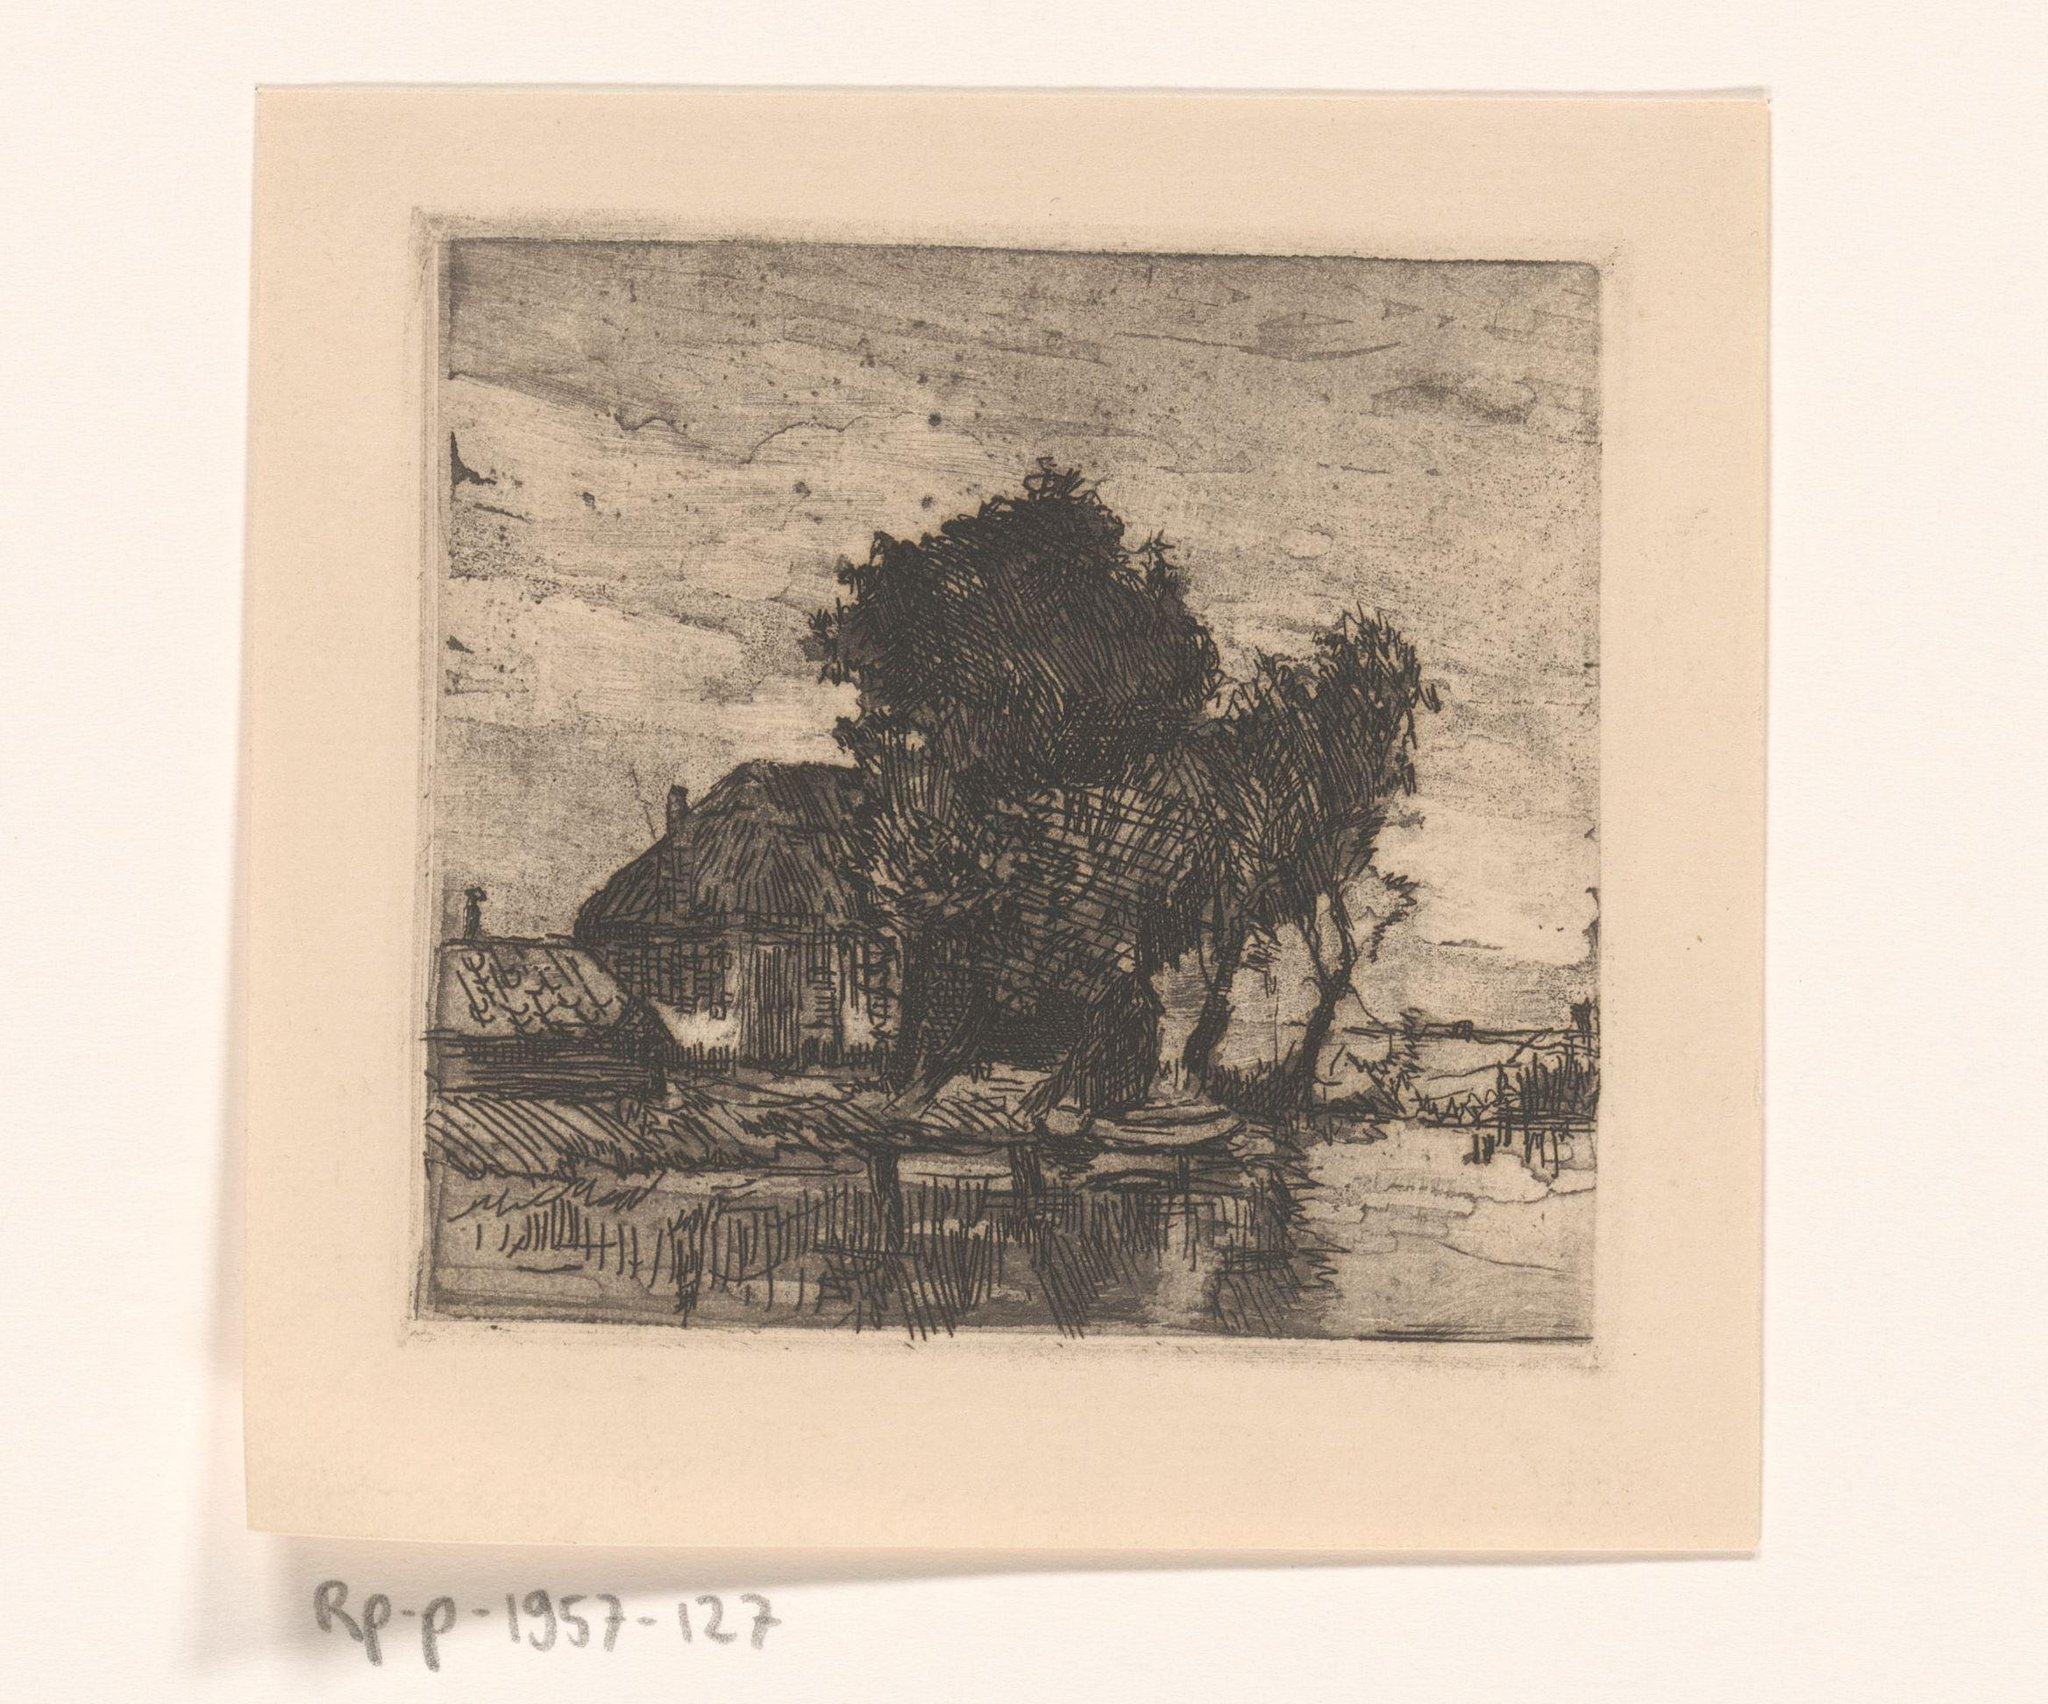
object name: print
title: Boerderij aan een plas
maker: chris van der windt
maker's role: print maker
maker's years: 1877-1952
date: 1887-1952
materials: paper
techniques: etching, intaglio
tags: farm or solitary house in landscape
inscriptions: collector's mark: Lugt 2228